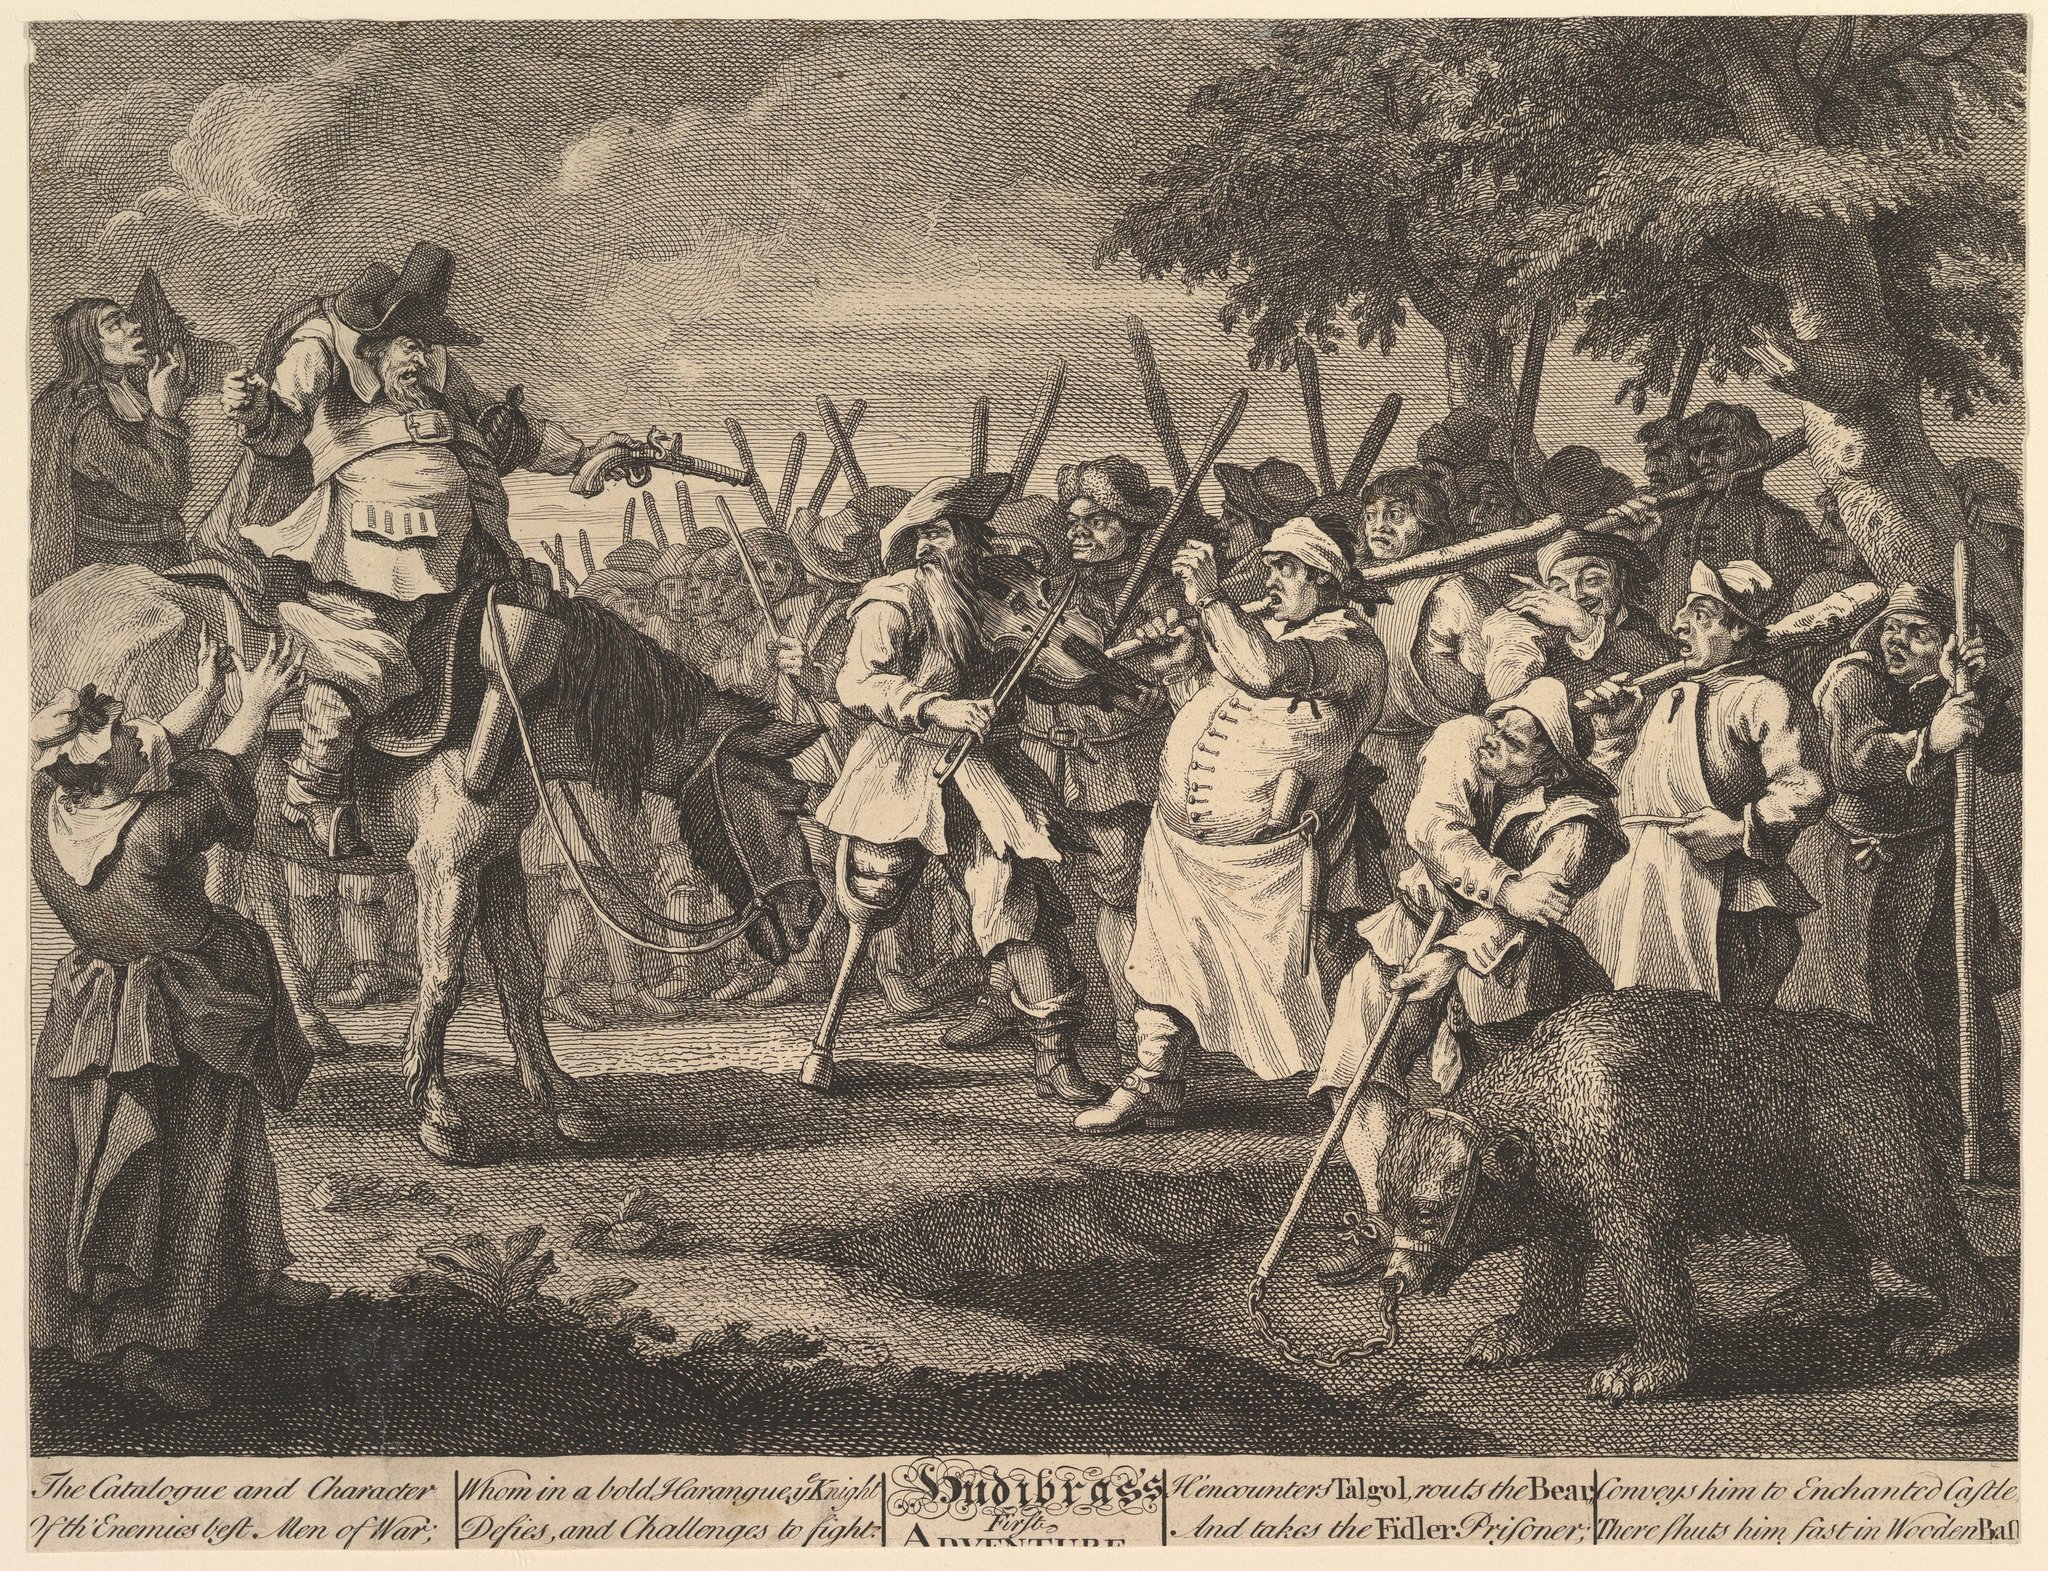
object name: print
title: Hudibras' First Adventure (Twelve Large Illustrations for Samuel Butler's Hudibras, Plate 3)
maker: william hogarth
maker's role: artist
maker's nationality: british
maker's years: 1697-1764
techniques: engraving, etching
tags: bears,firearms,men,horses,crowd